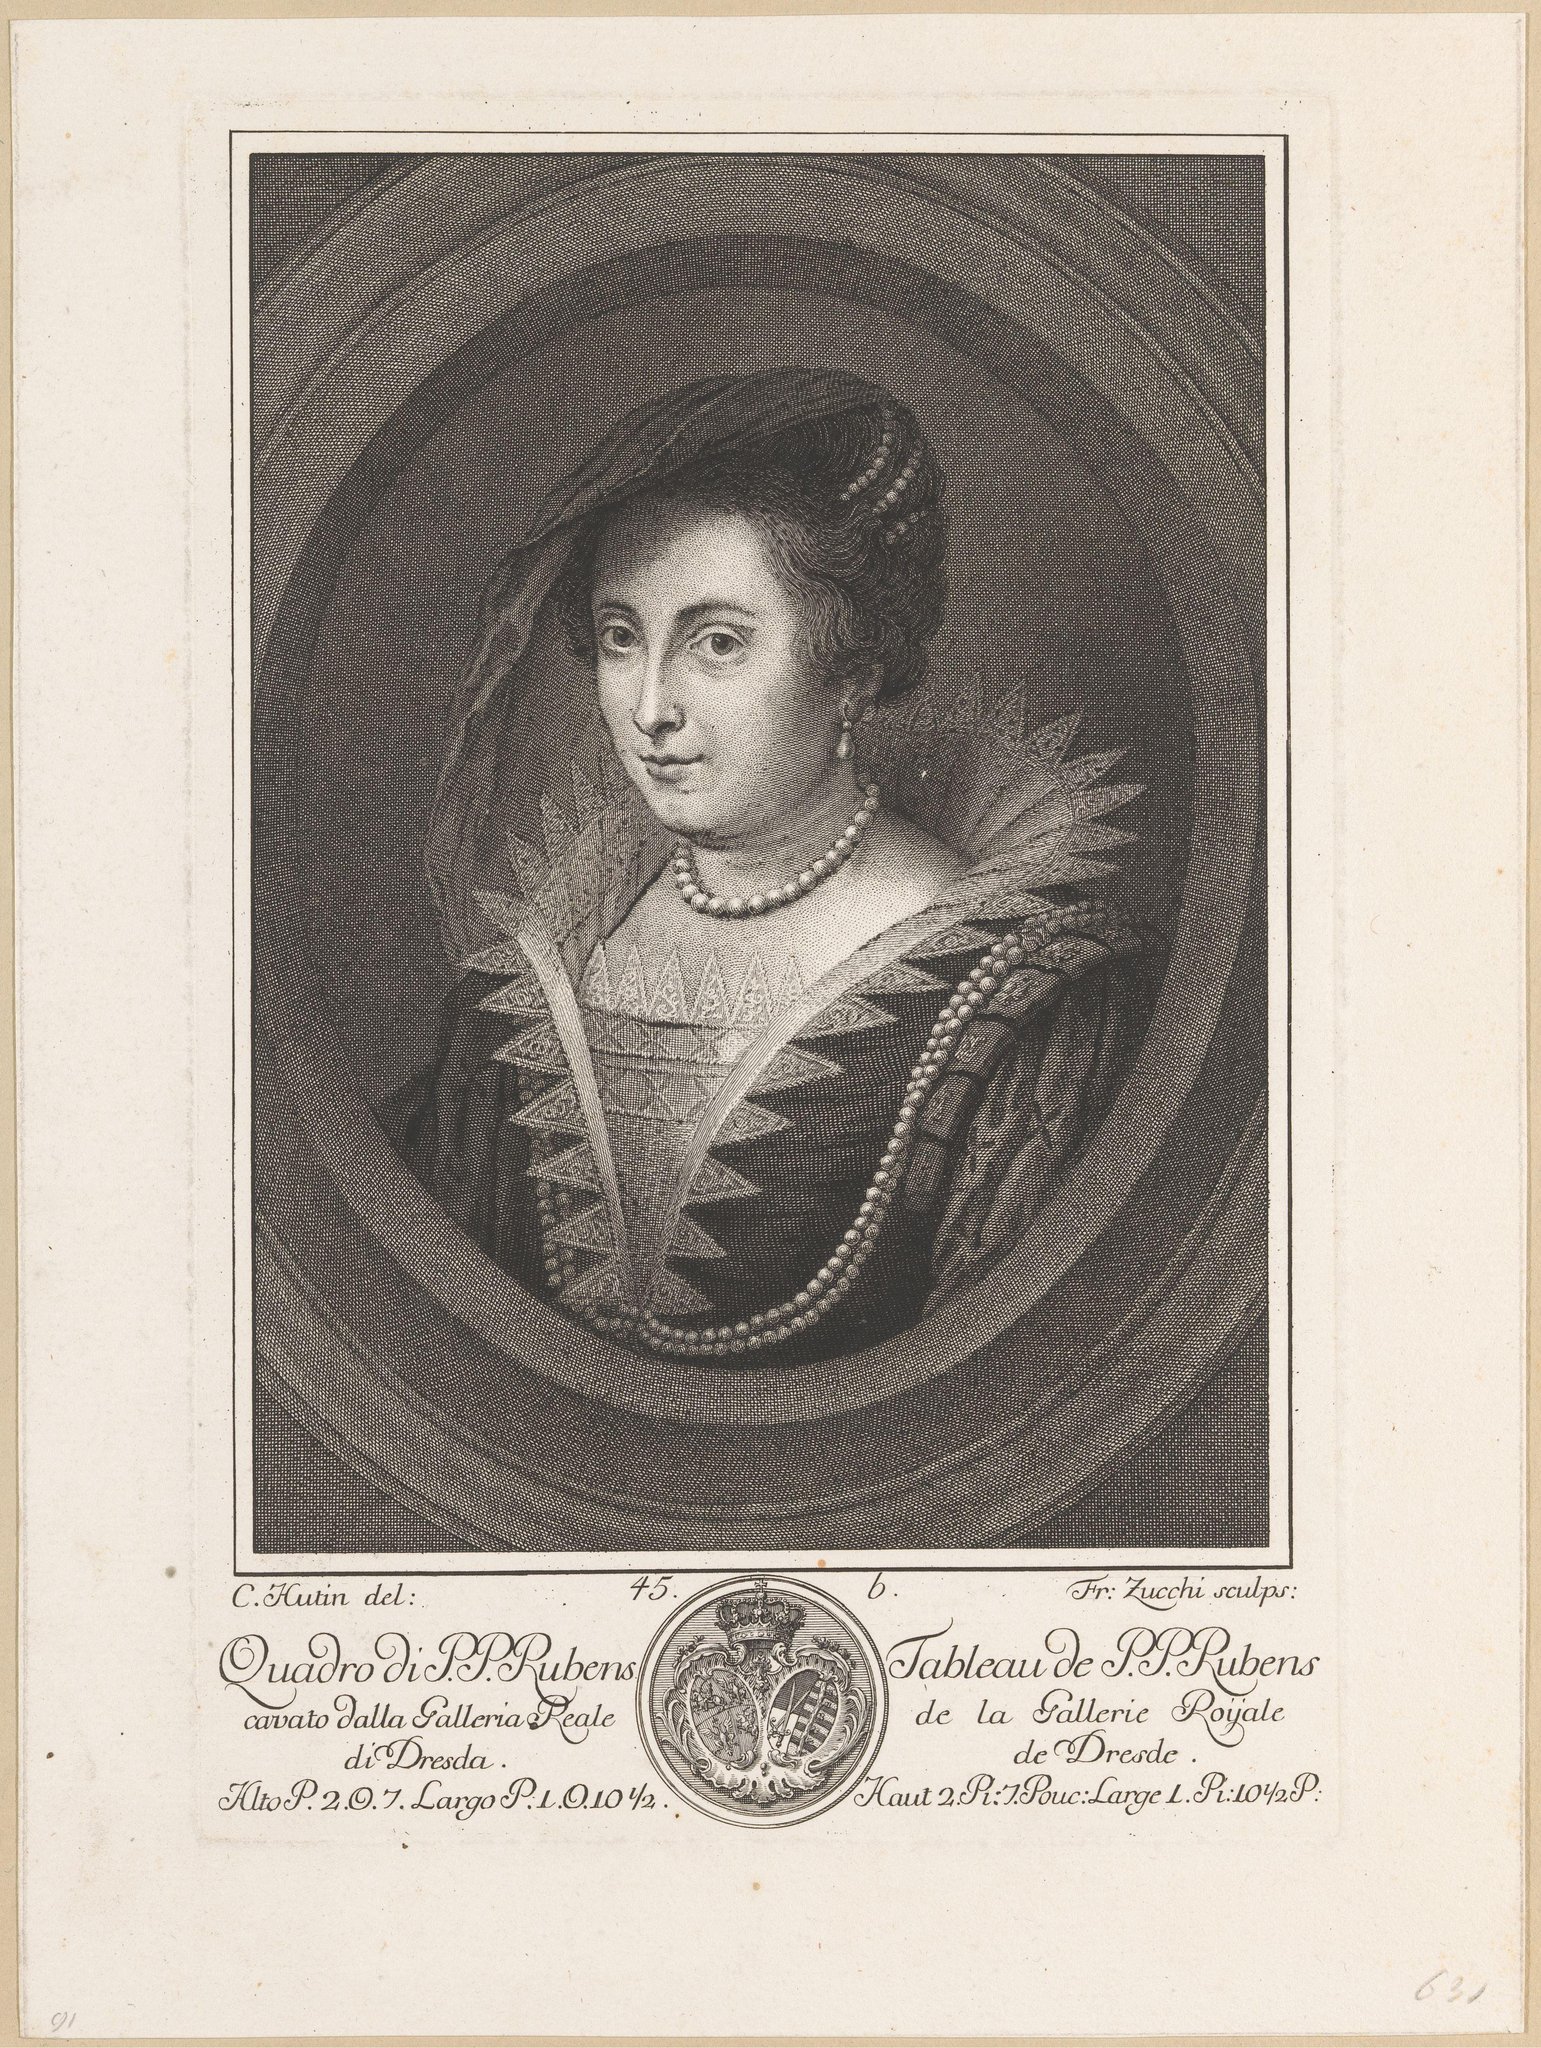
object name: print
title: Schilderijen te Dresden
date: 1753-1757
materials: paper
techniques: engraving, etching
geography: italy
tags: historical persons, armorial bearing, heraldry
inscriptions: collector's mark: Lugt 240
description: Prent afkomstig uit de 'Recueil d'estampes d'après les plus célèbres tableaux de la Galerie Royale de Dresde', verschenen in twee delen in 1753 en 1757, met in totaal 100 prenten naar schilderijen in de koninklijke kunstcollecties te Dresden.